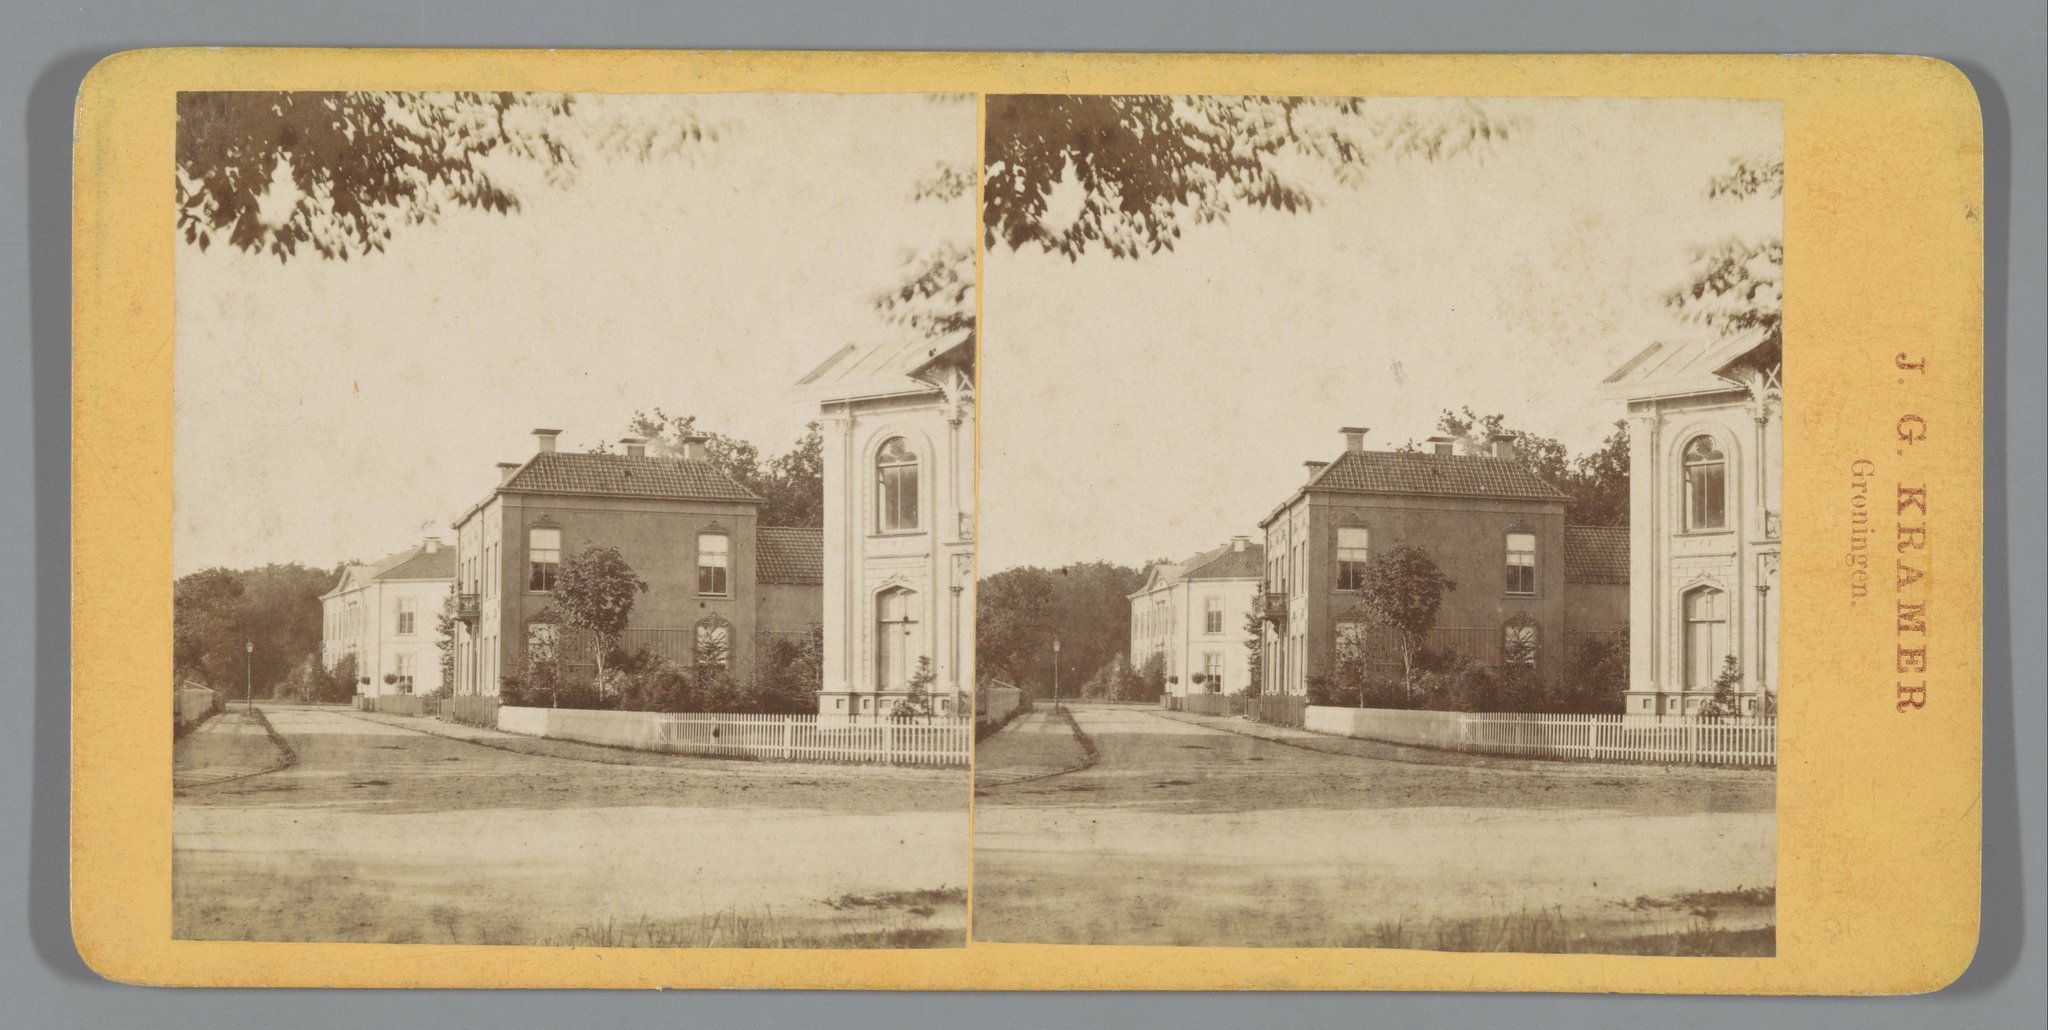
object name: stereograph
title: Assen, kantoor van hypotheken & kadaster en HB school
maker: johannes gerardus kramer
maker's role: fotograaf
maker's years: 1845-1903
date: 1868-1890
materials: cardboard, paper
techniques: albumen print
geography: assen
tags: street